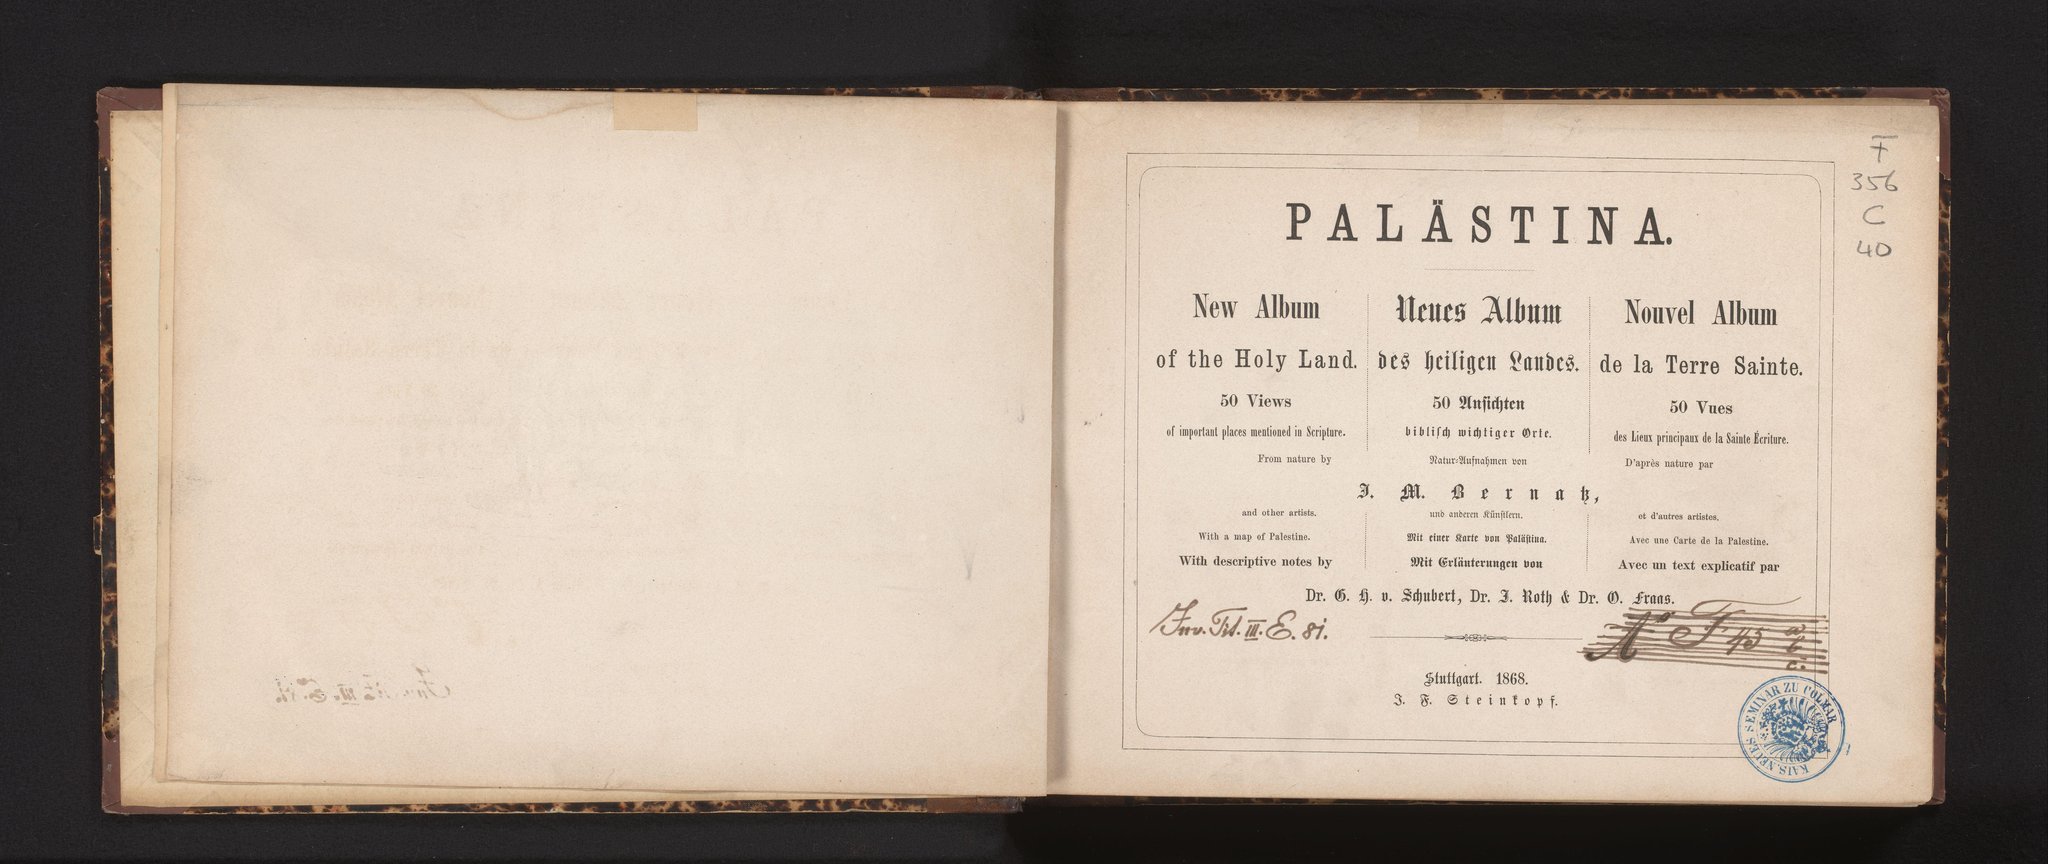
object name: book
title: Palästina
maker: j.f. steinkopf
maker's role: publisher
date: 1868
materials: cardboard, leather, paper, photographic support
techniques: albumen print, lithograph, printing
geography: stuttgart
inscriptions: inscription: ‘Kais. neues seminar zu Colmar’, inscription: ‘Inv. Foto III. E. si.’